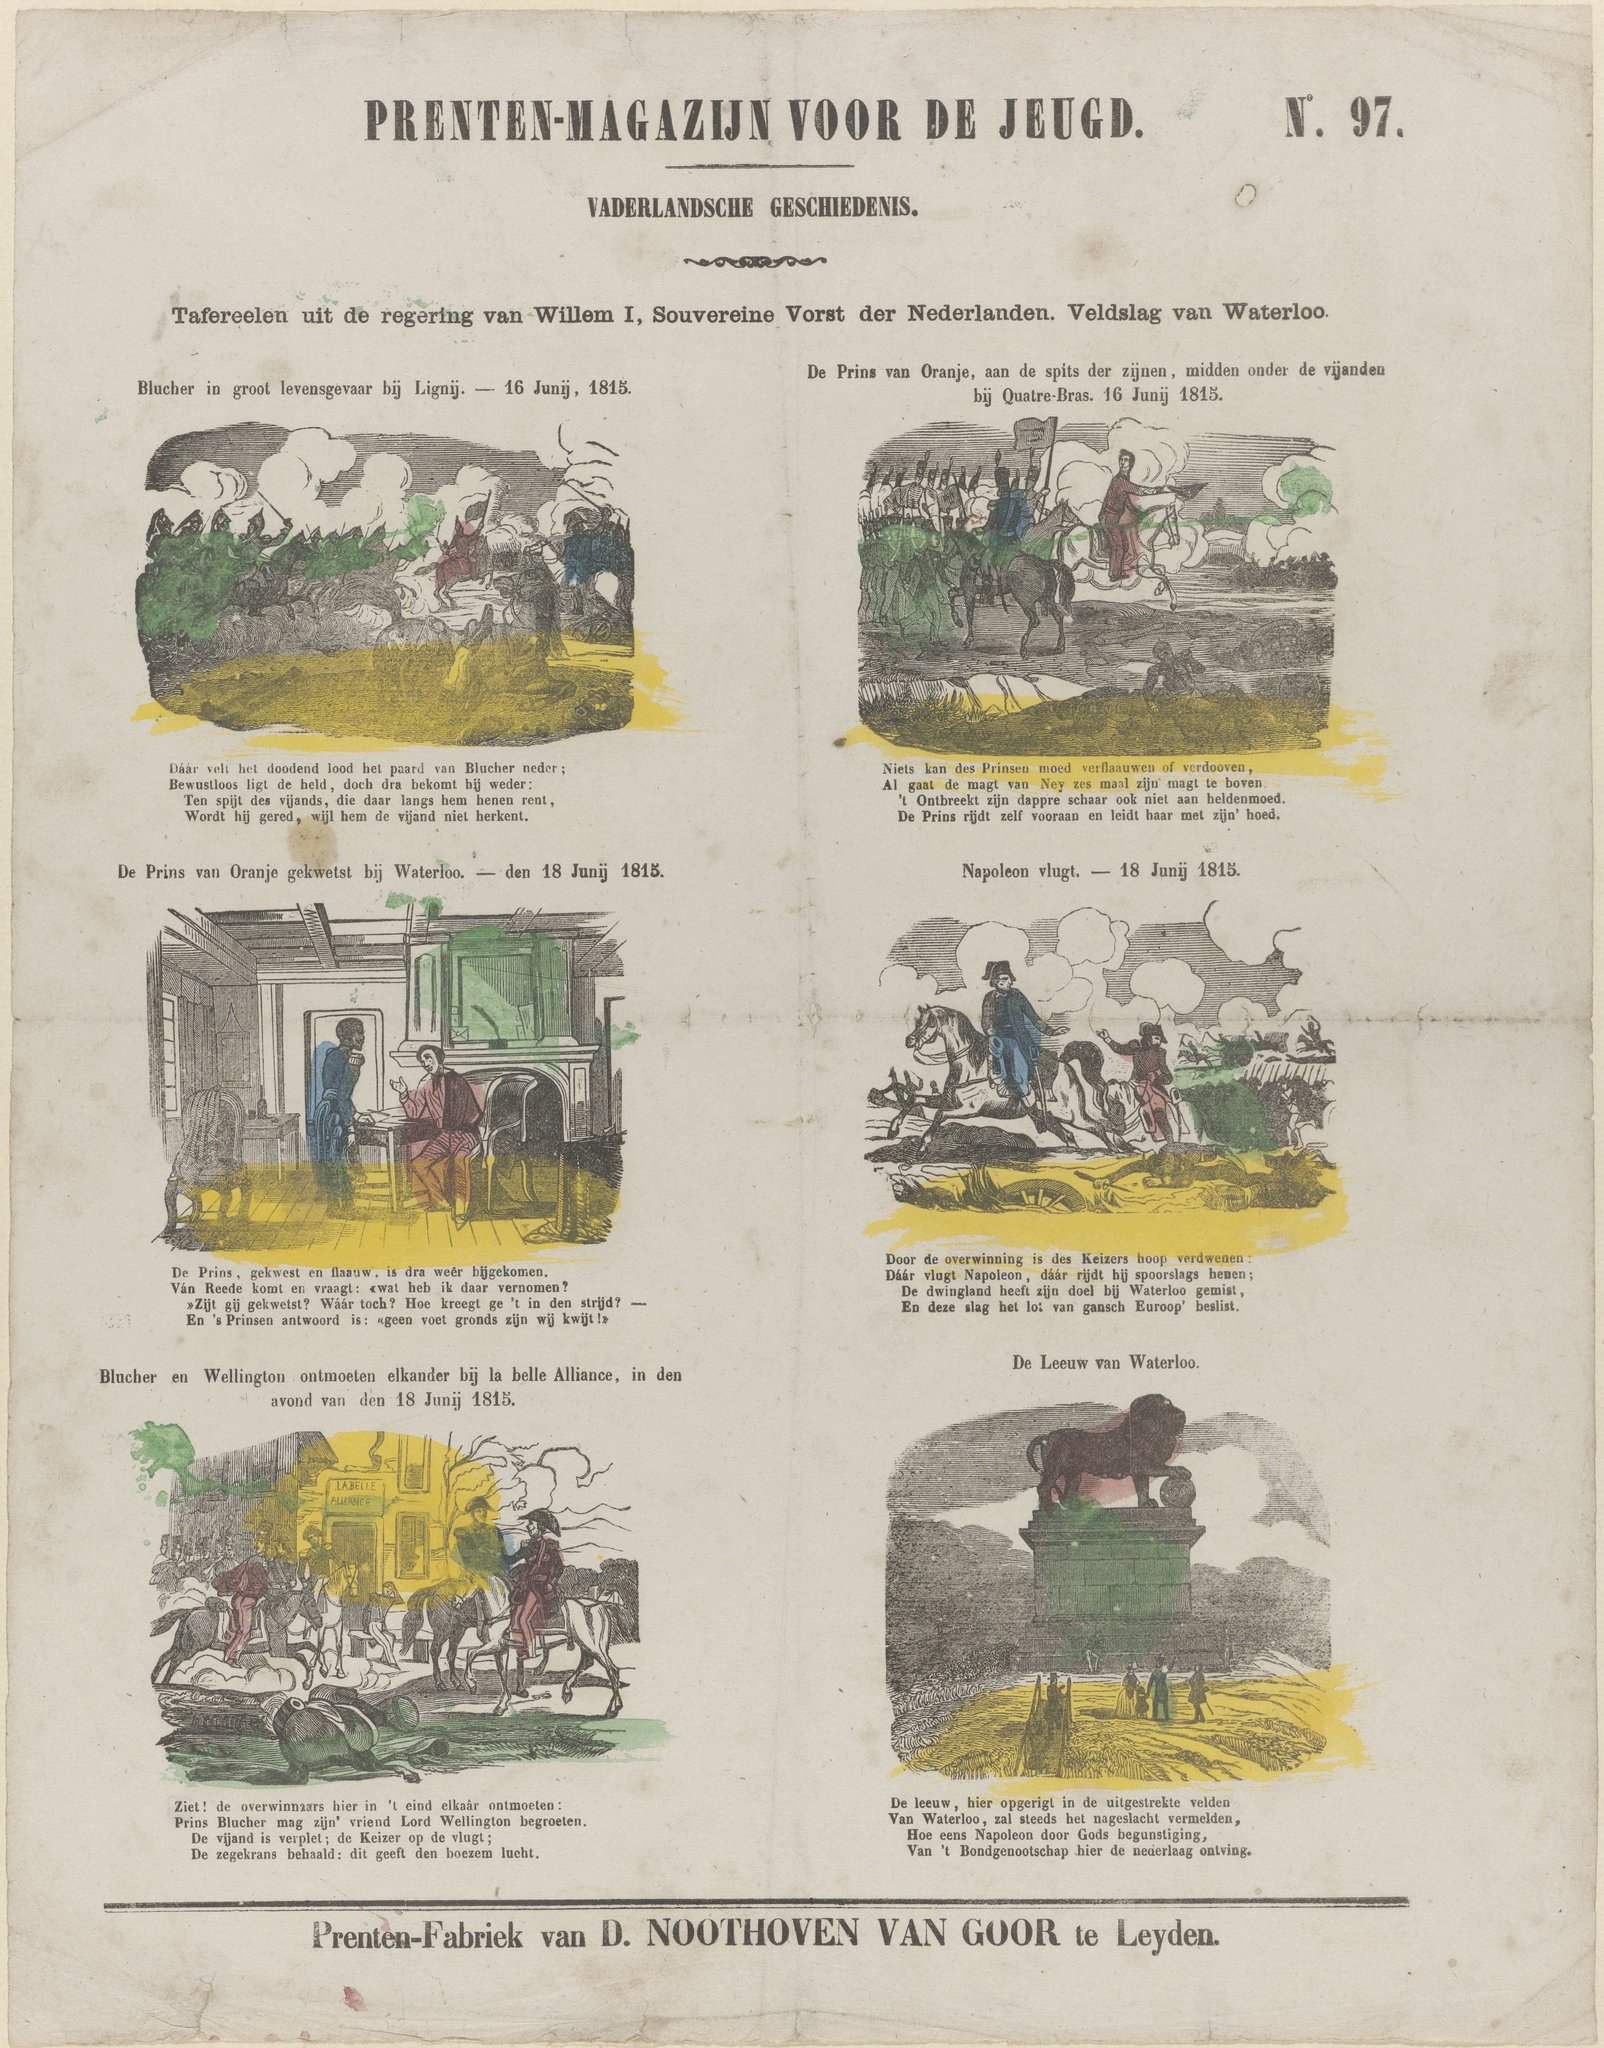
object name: popular print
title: Tafereelen uit de regering van Willem I, souvereine vorst der Nederlanden. Veldslag van Waterloo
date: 1850-1881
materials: paper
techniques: colour, letterpress printing, engraving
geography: leiden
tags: the hague, berlin, william i of the netherlands, walmer castle, arthur wellesley of wellington, napoleon i (emperor of the french), history, waterloo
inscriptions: collector's mark: Lugt 2760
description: Blad met 6 voorstellingen over de Slag bij Waterloo. Boven elke voorstelling een titel en onder elke voorstelling een vierregelig vers. Genummerd rechtsboven: No. 97.